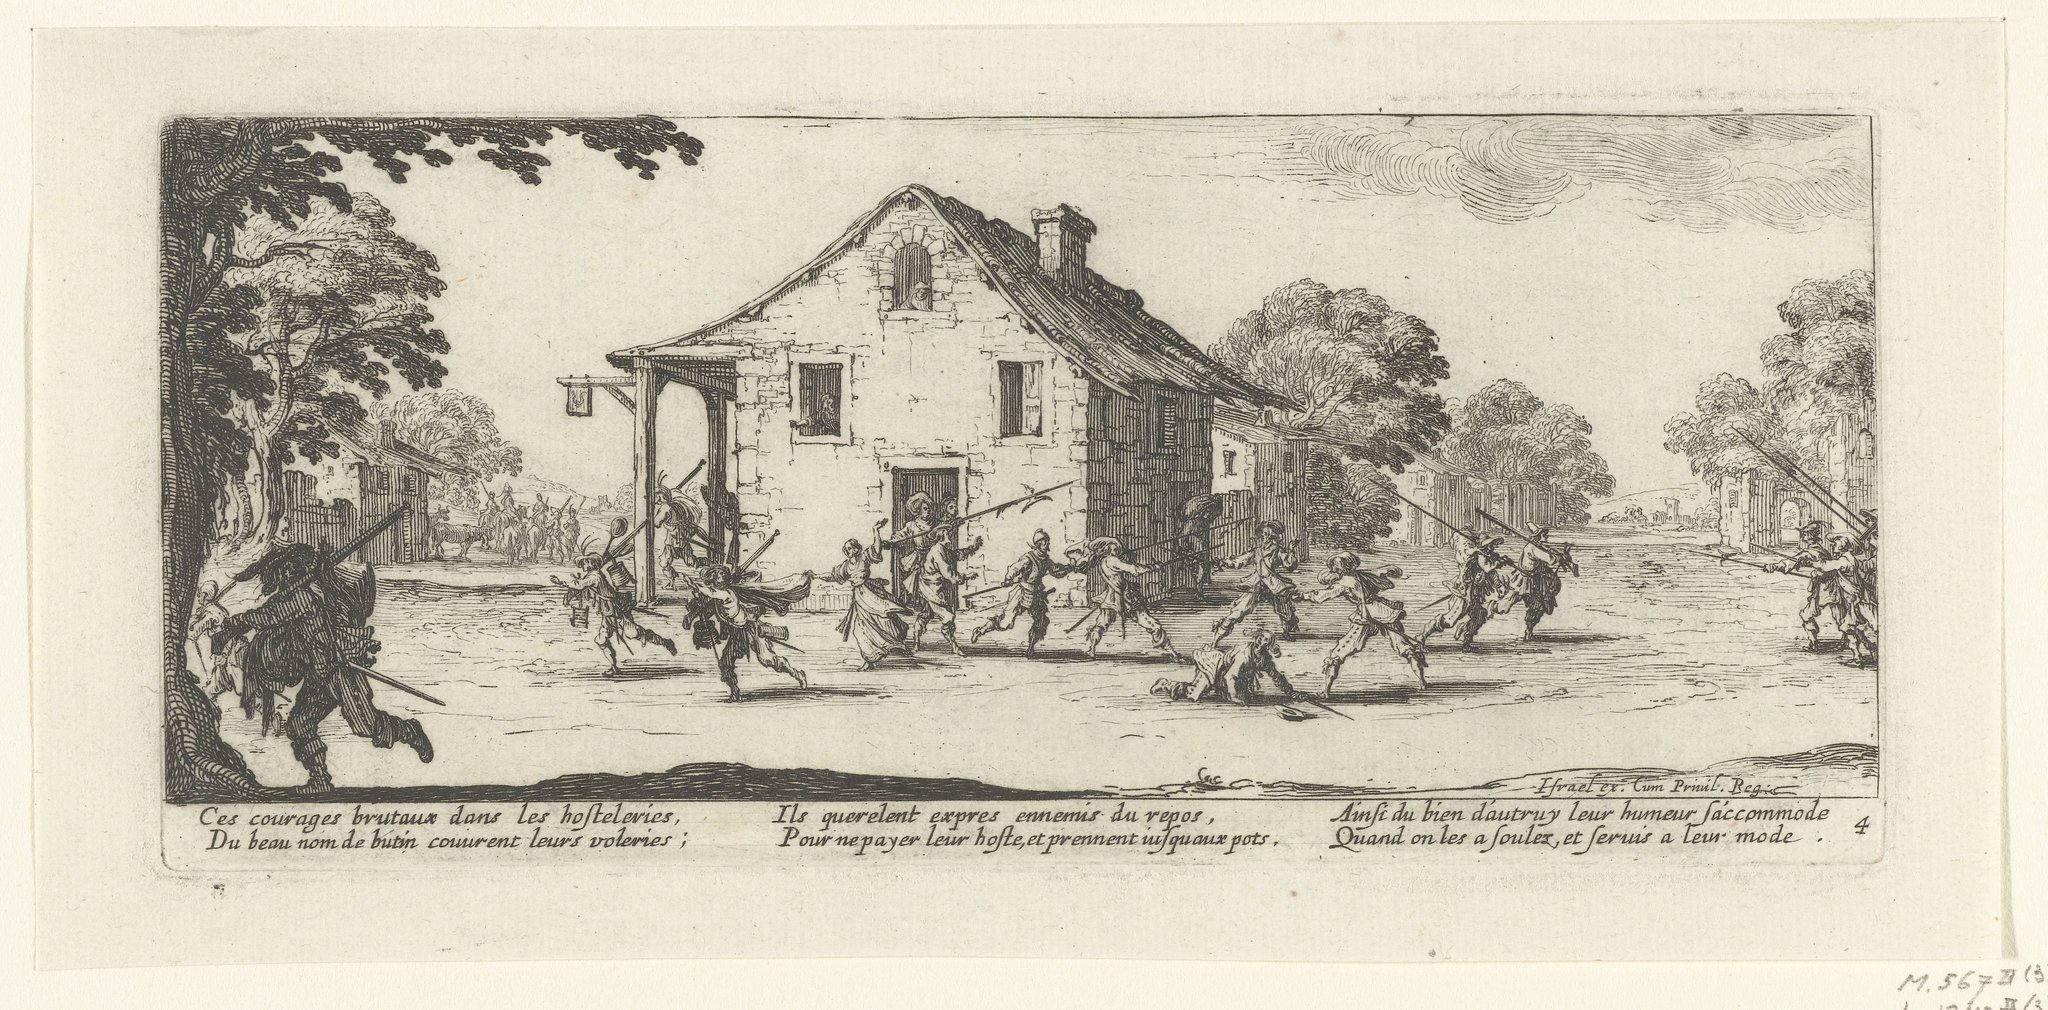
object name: print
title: De gruwelen van de oorlog (groot)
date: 1633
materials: paper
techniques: etching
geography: paris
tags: plundering ~ soldiers, soldiers and civilians, hotel, hostelry, inn, fighting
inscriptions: collector's mark: Lugt 240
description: Soldaten verlaten al vechtend een herberg die ze zojuist geplunderd hebben. Onder de voorstelling een zesregelig Frans vers. Deze prent is onderdeel van een serie van 17 (18 incl. titelprent) prenten met voorstellingen van diverse soorten ellende die oorlogvoering met zich meebrengt.